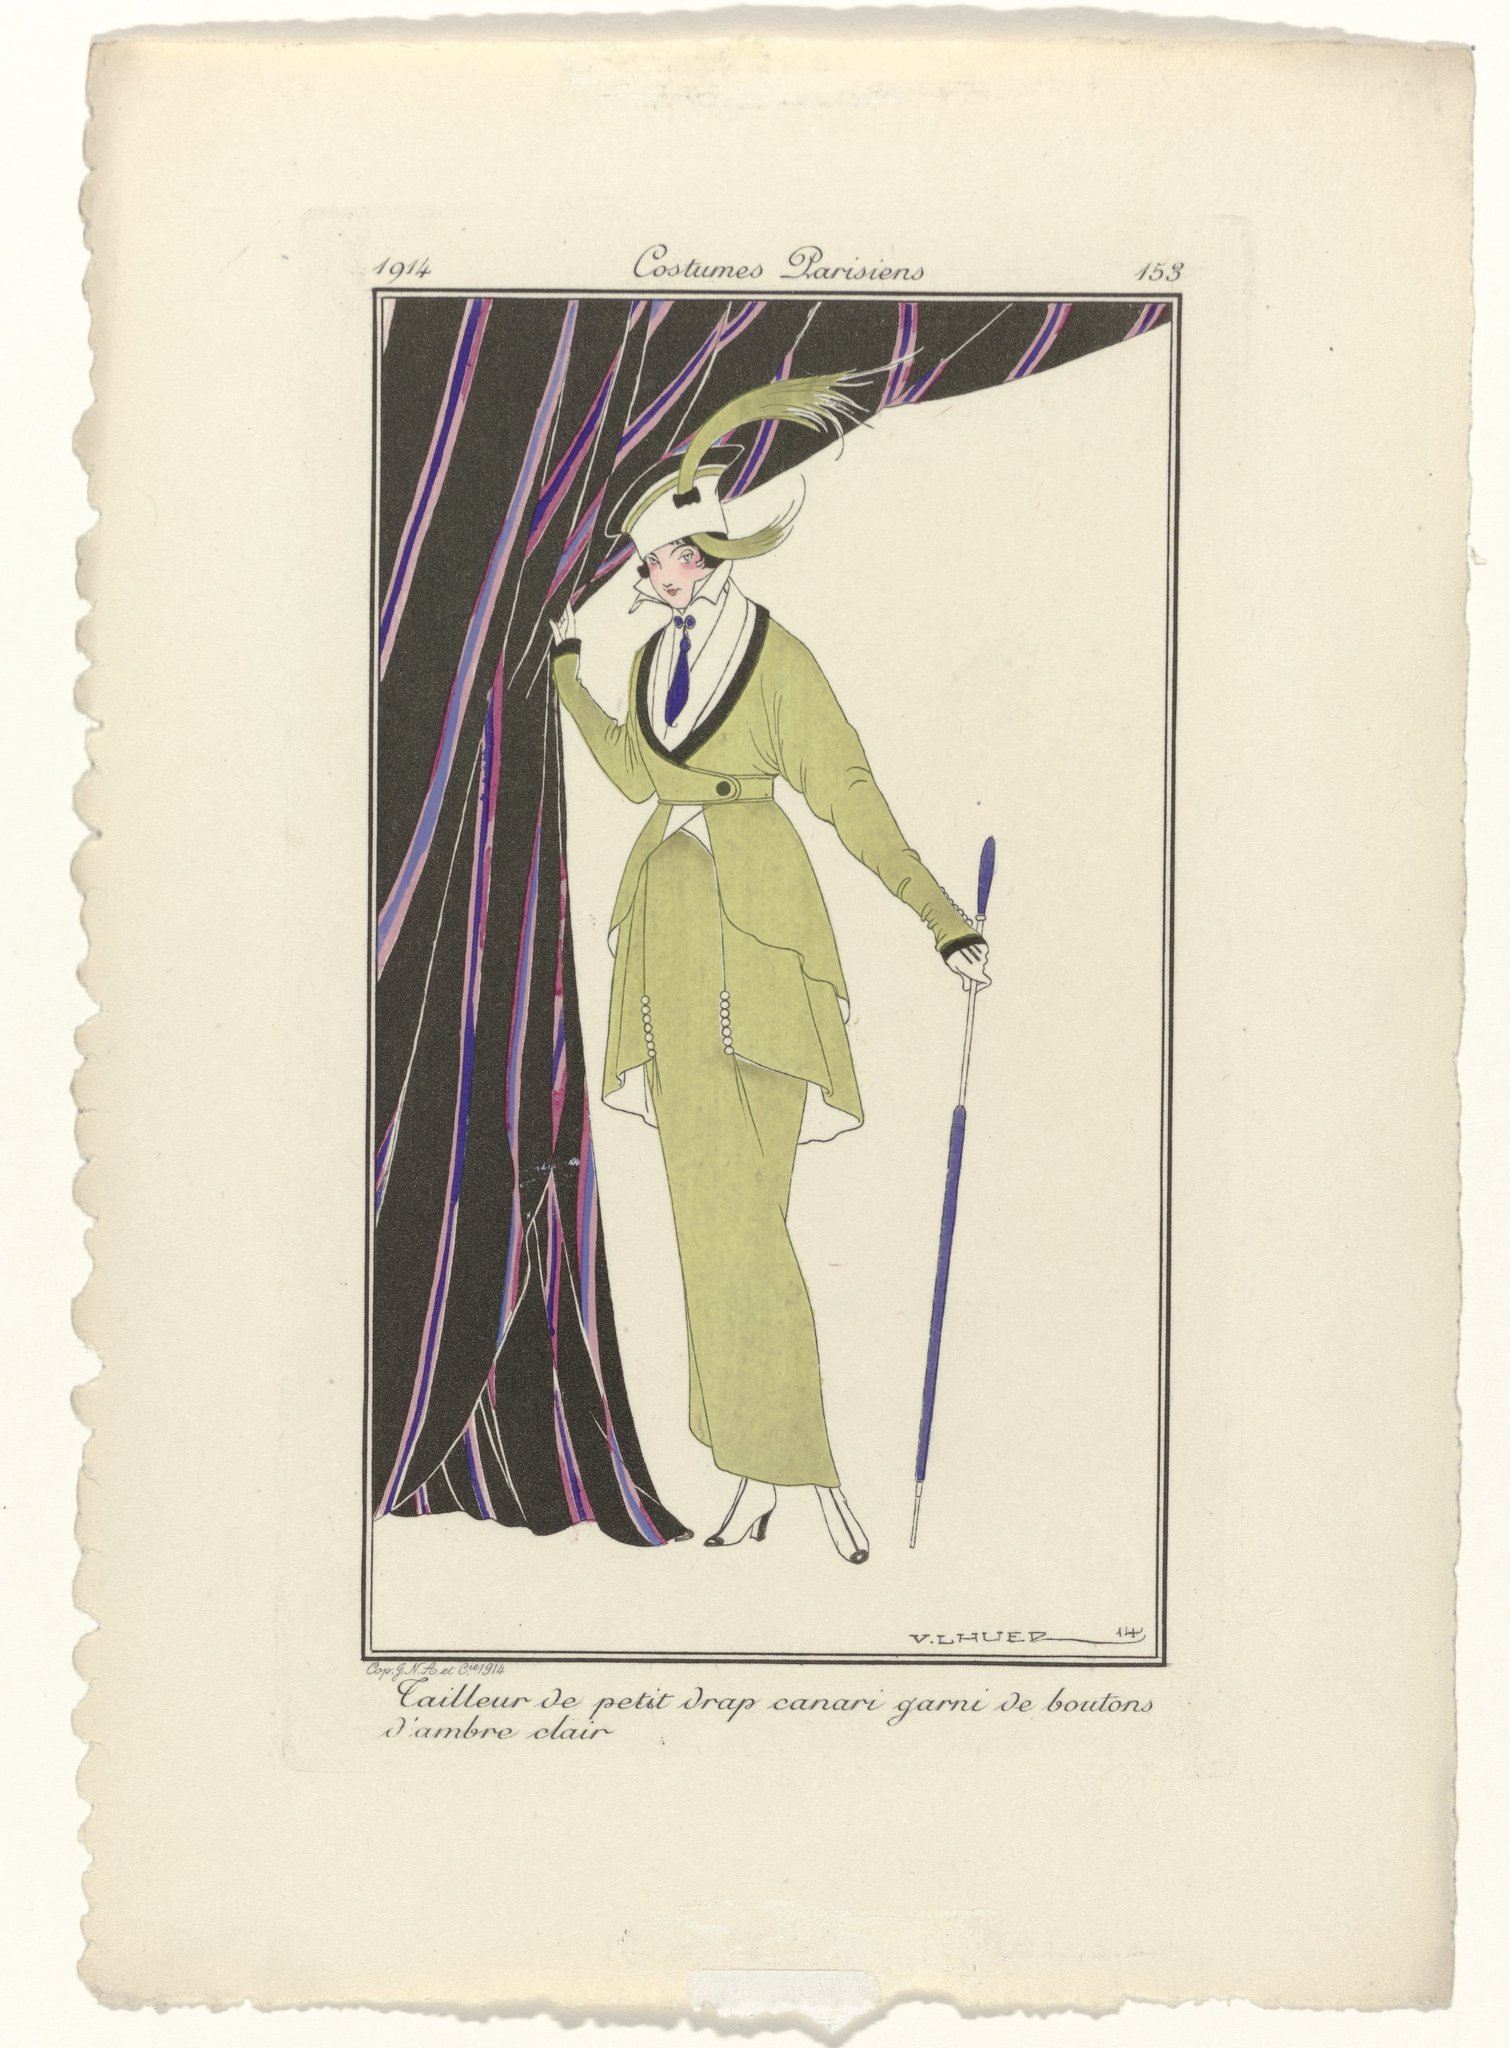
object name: fashion print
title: Journal des Dames et des Modes, Costumes Parisiens, 1914, No. 153 : Tailleur de petit drap (...)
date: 1914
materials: paper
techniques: engraving, hand coloring, pochoir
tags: curtains, walking-stick, staff, cane (+ women's clothes), ensembles of pieces of clothing (suit) (+ women's clothes), button (+ other materials used for clothes), head-gear (+ women's clothes), fashion plates, skirt (+ women's clothes)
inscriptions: title: ‘Costumes Parisiens’, inscription: ‘Cop. J. N. A. et Cie 1914’, caption: ‘Tailleur de petit drap canari garni de boutons d'ambre clair’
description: Mantelpak van kanariegeel (groen) laken, versierd met knopen van licht barnsteen. Prent uit het modetijdschrift Journal des Dames et des Modes (1912-1914).